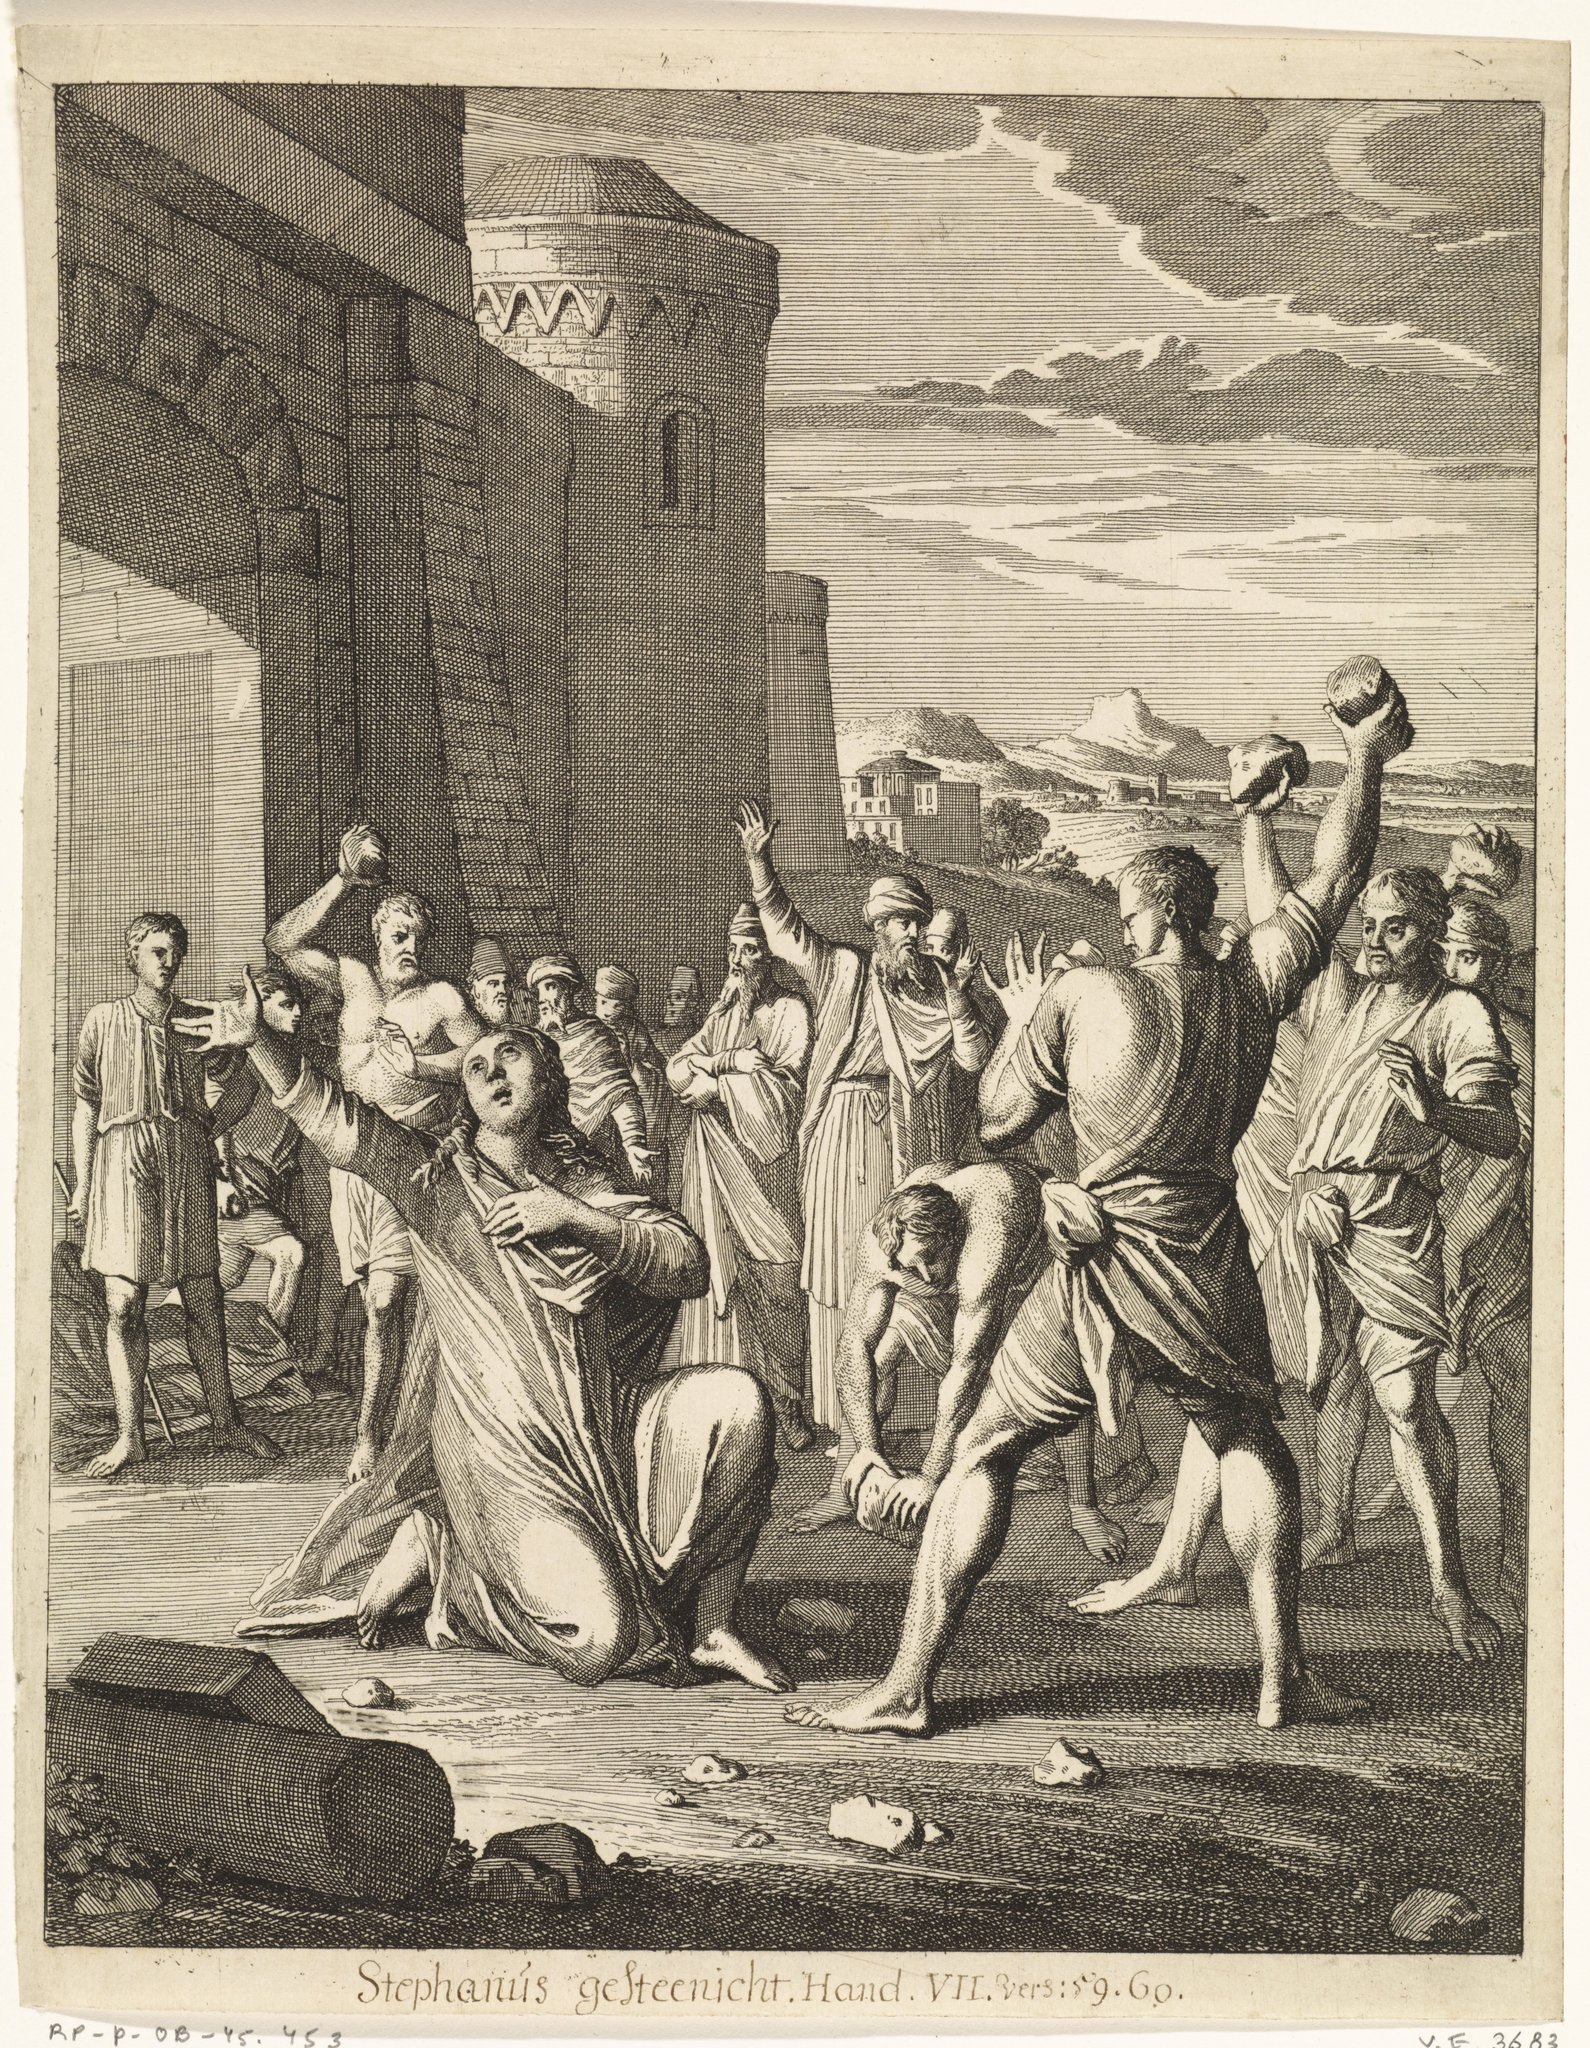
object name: print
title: Steniging van Stefanus buiten de poorten van Jeruzalem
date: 1708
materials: paper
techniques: etching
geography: nuremberg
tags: the stoning of stephen; the witnesses lay down their clothes at saul's feet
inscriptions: collector's mark: Lugt 2228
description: Proefdruk van een prent welke is opgenomen als illustratie in: Historiae Celebriores Veteris Testamenti. Christoph Weigel, 1708.